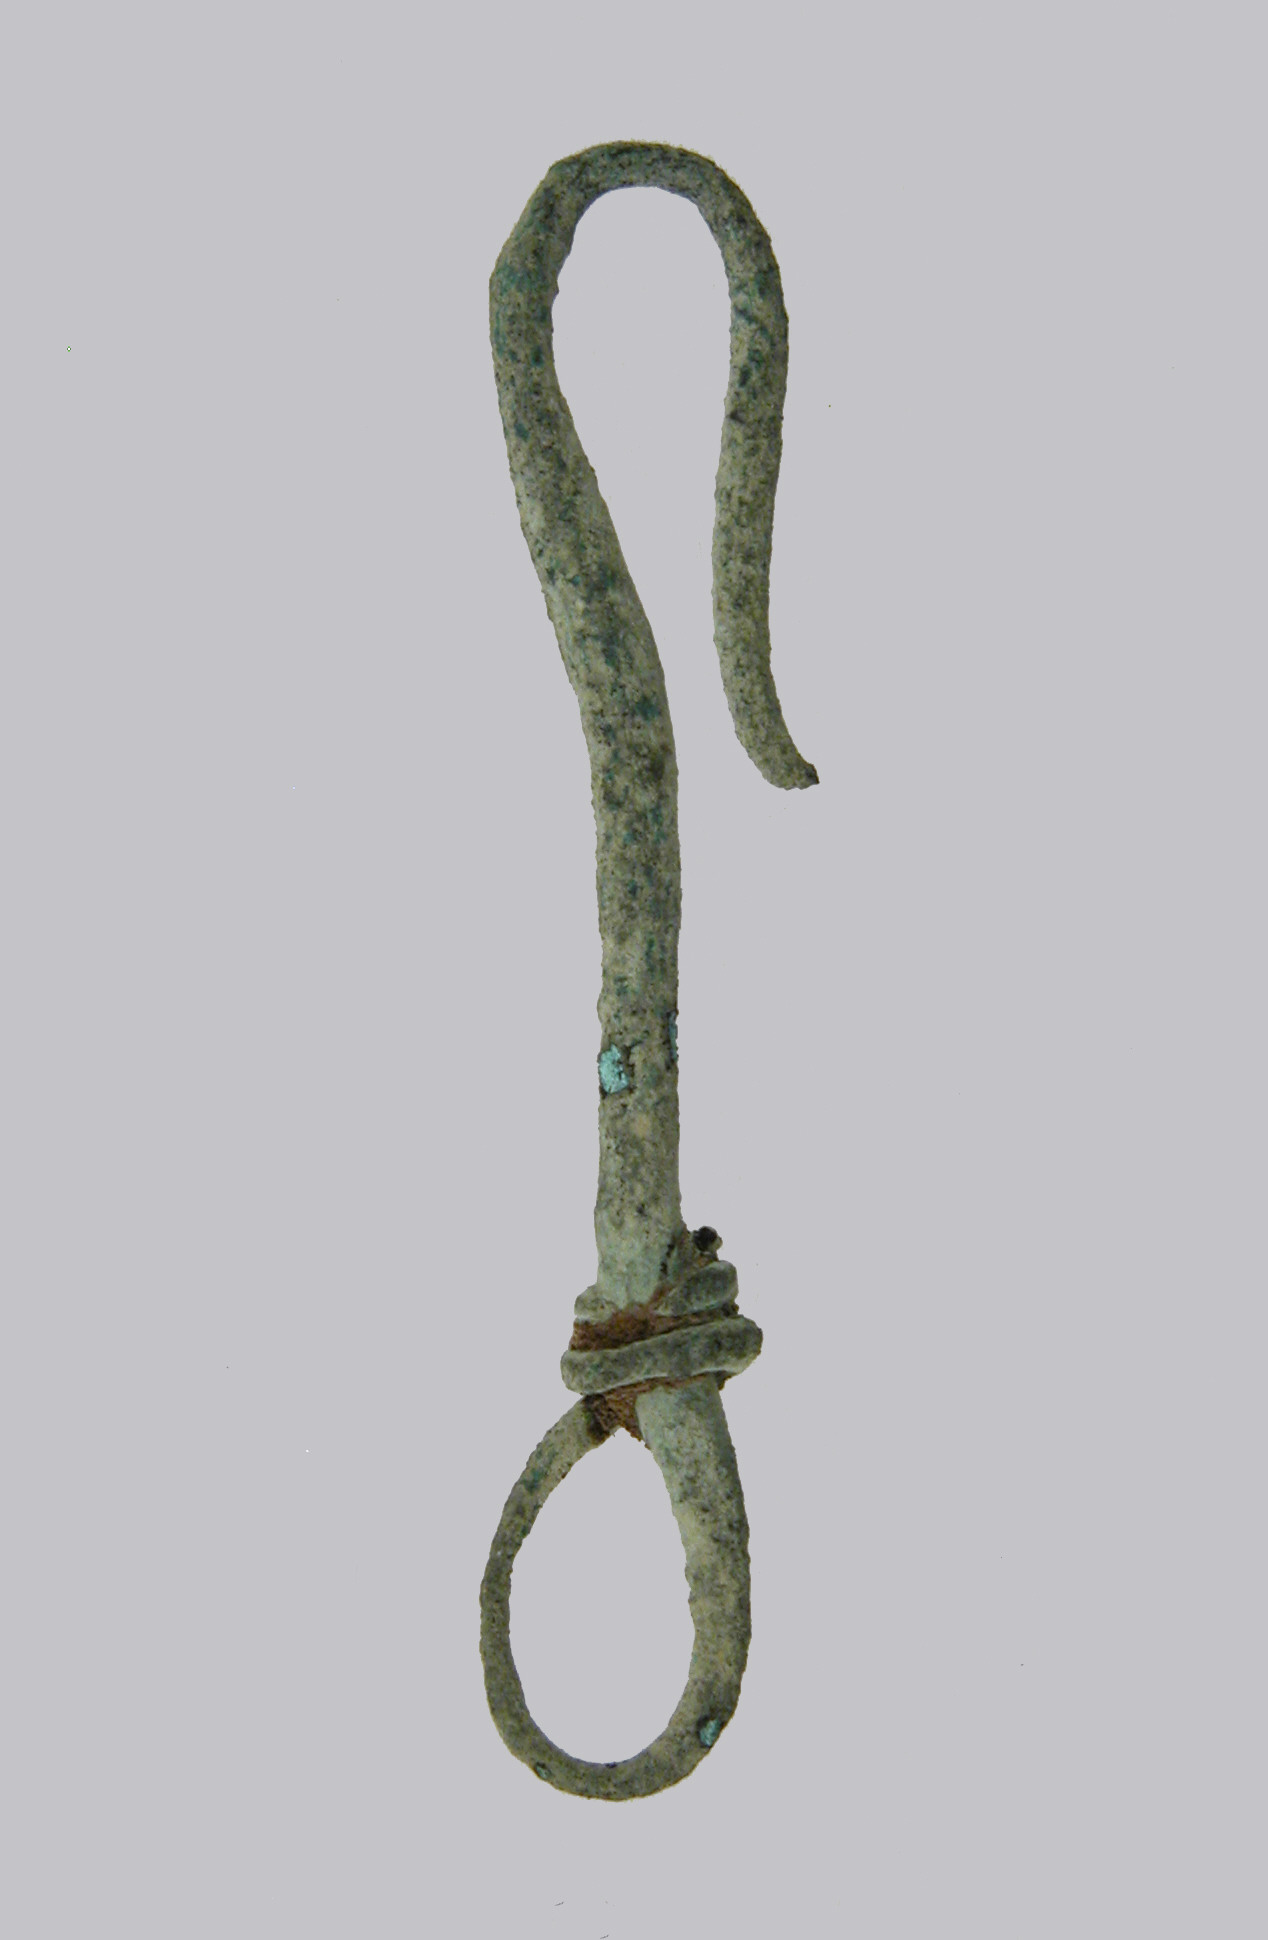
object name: earring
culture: frankish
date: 601-700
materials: copper alloy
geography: germany